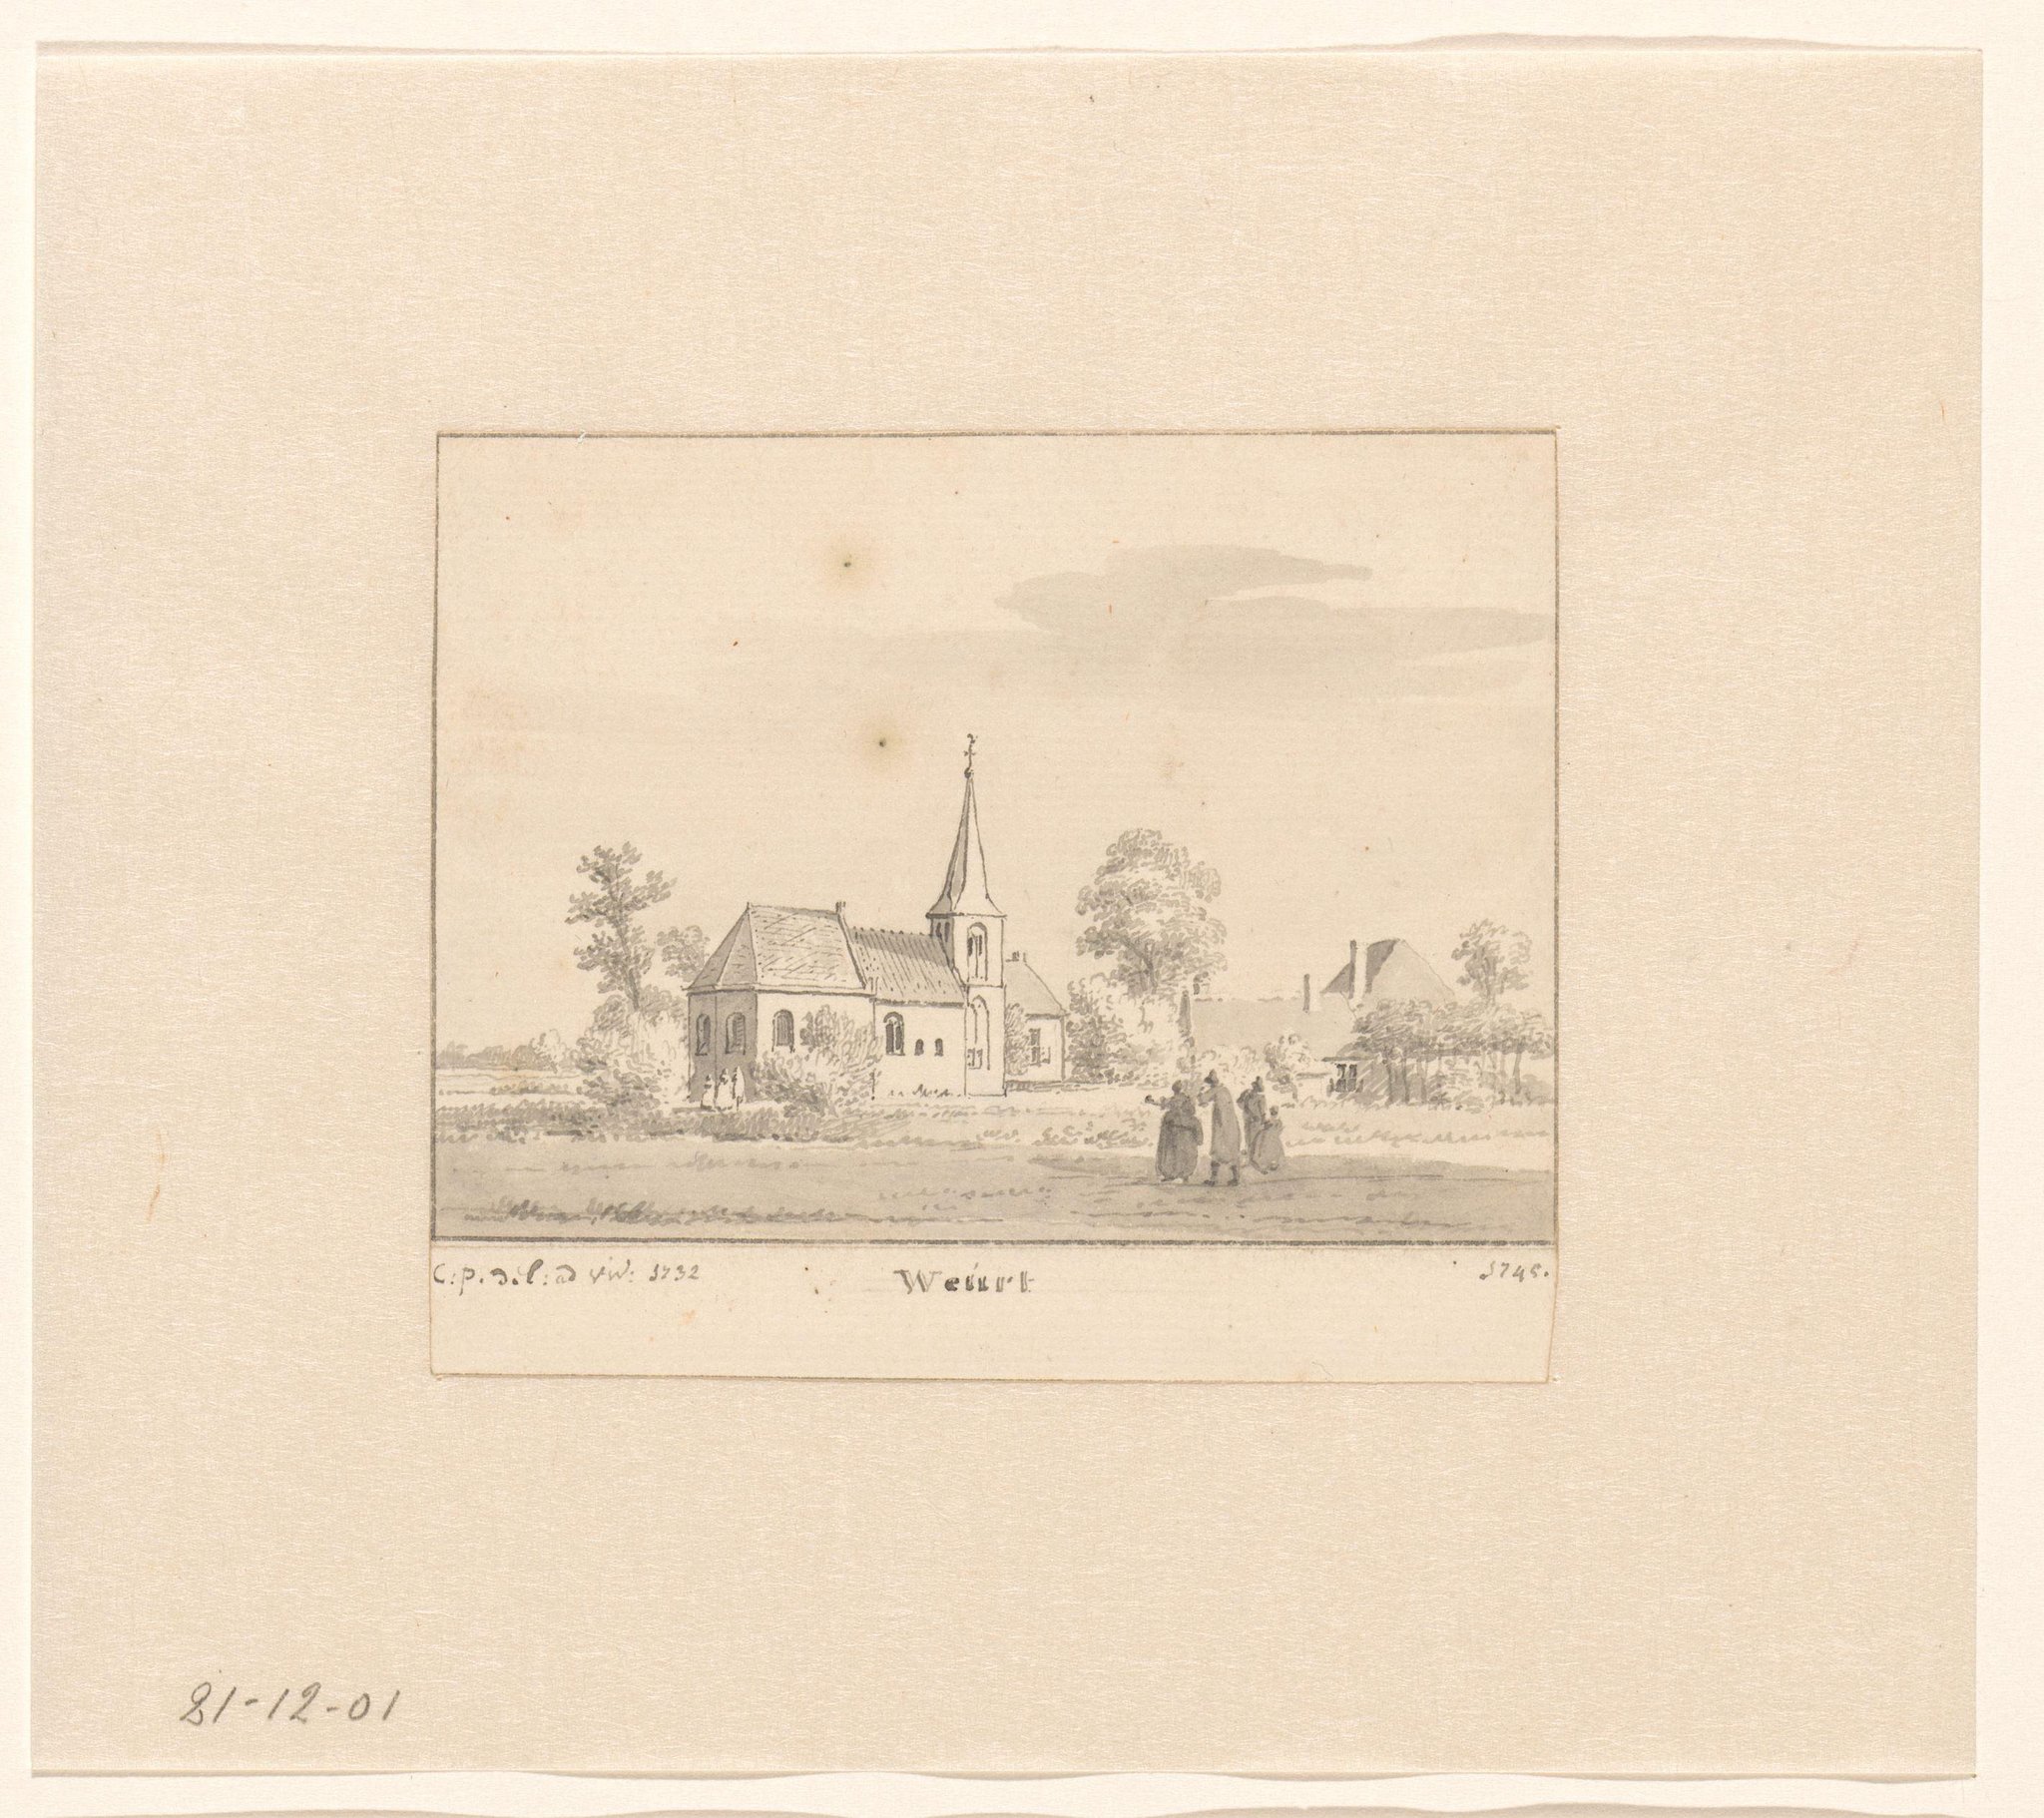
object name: drawing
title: De kerk van Weurt, Gelderland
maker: cornelis pronk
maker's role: draughtsman, painter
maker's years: 1691-1759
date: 1732-1748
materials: ink, paper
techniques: brush, pen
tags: prospect of village, silhouette of village, church (exterior)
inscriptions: caption: ‘C:p del: ad viv 1732 / Weurt / 1748’